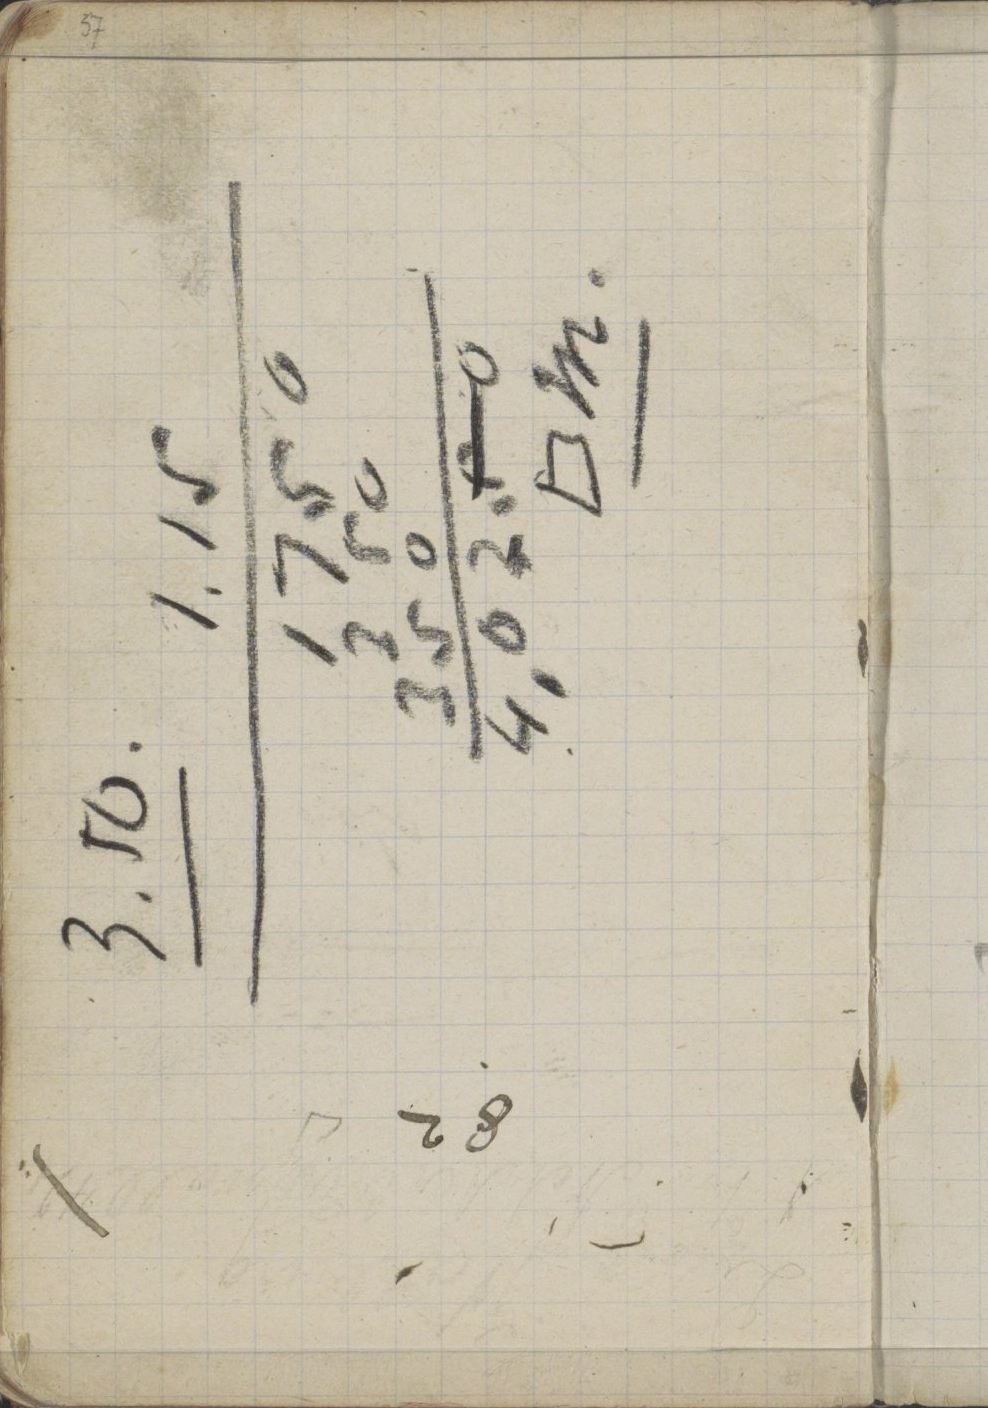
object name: sketchbook leaf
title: Getallen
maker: george hendrik breitner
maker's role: draughtsman, painter, print maker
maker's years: 1857-1923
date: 1893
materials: chalk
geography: amsterdam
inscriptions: annotation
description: Pagina 57 uit een schetsboek met 30 bladen vervaardigd in Amsterdam.